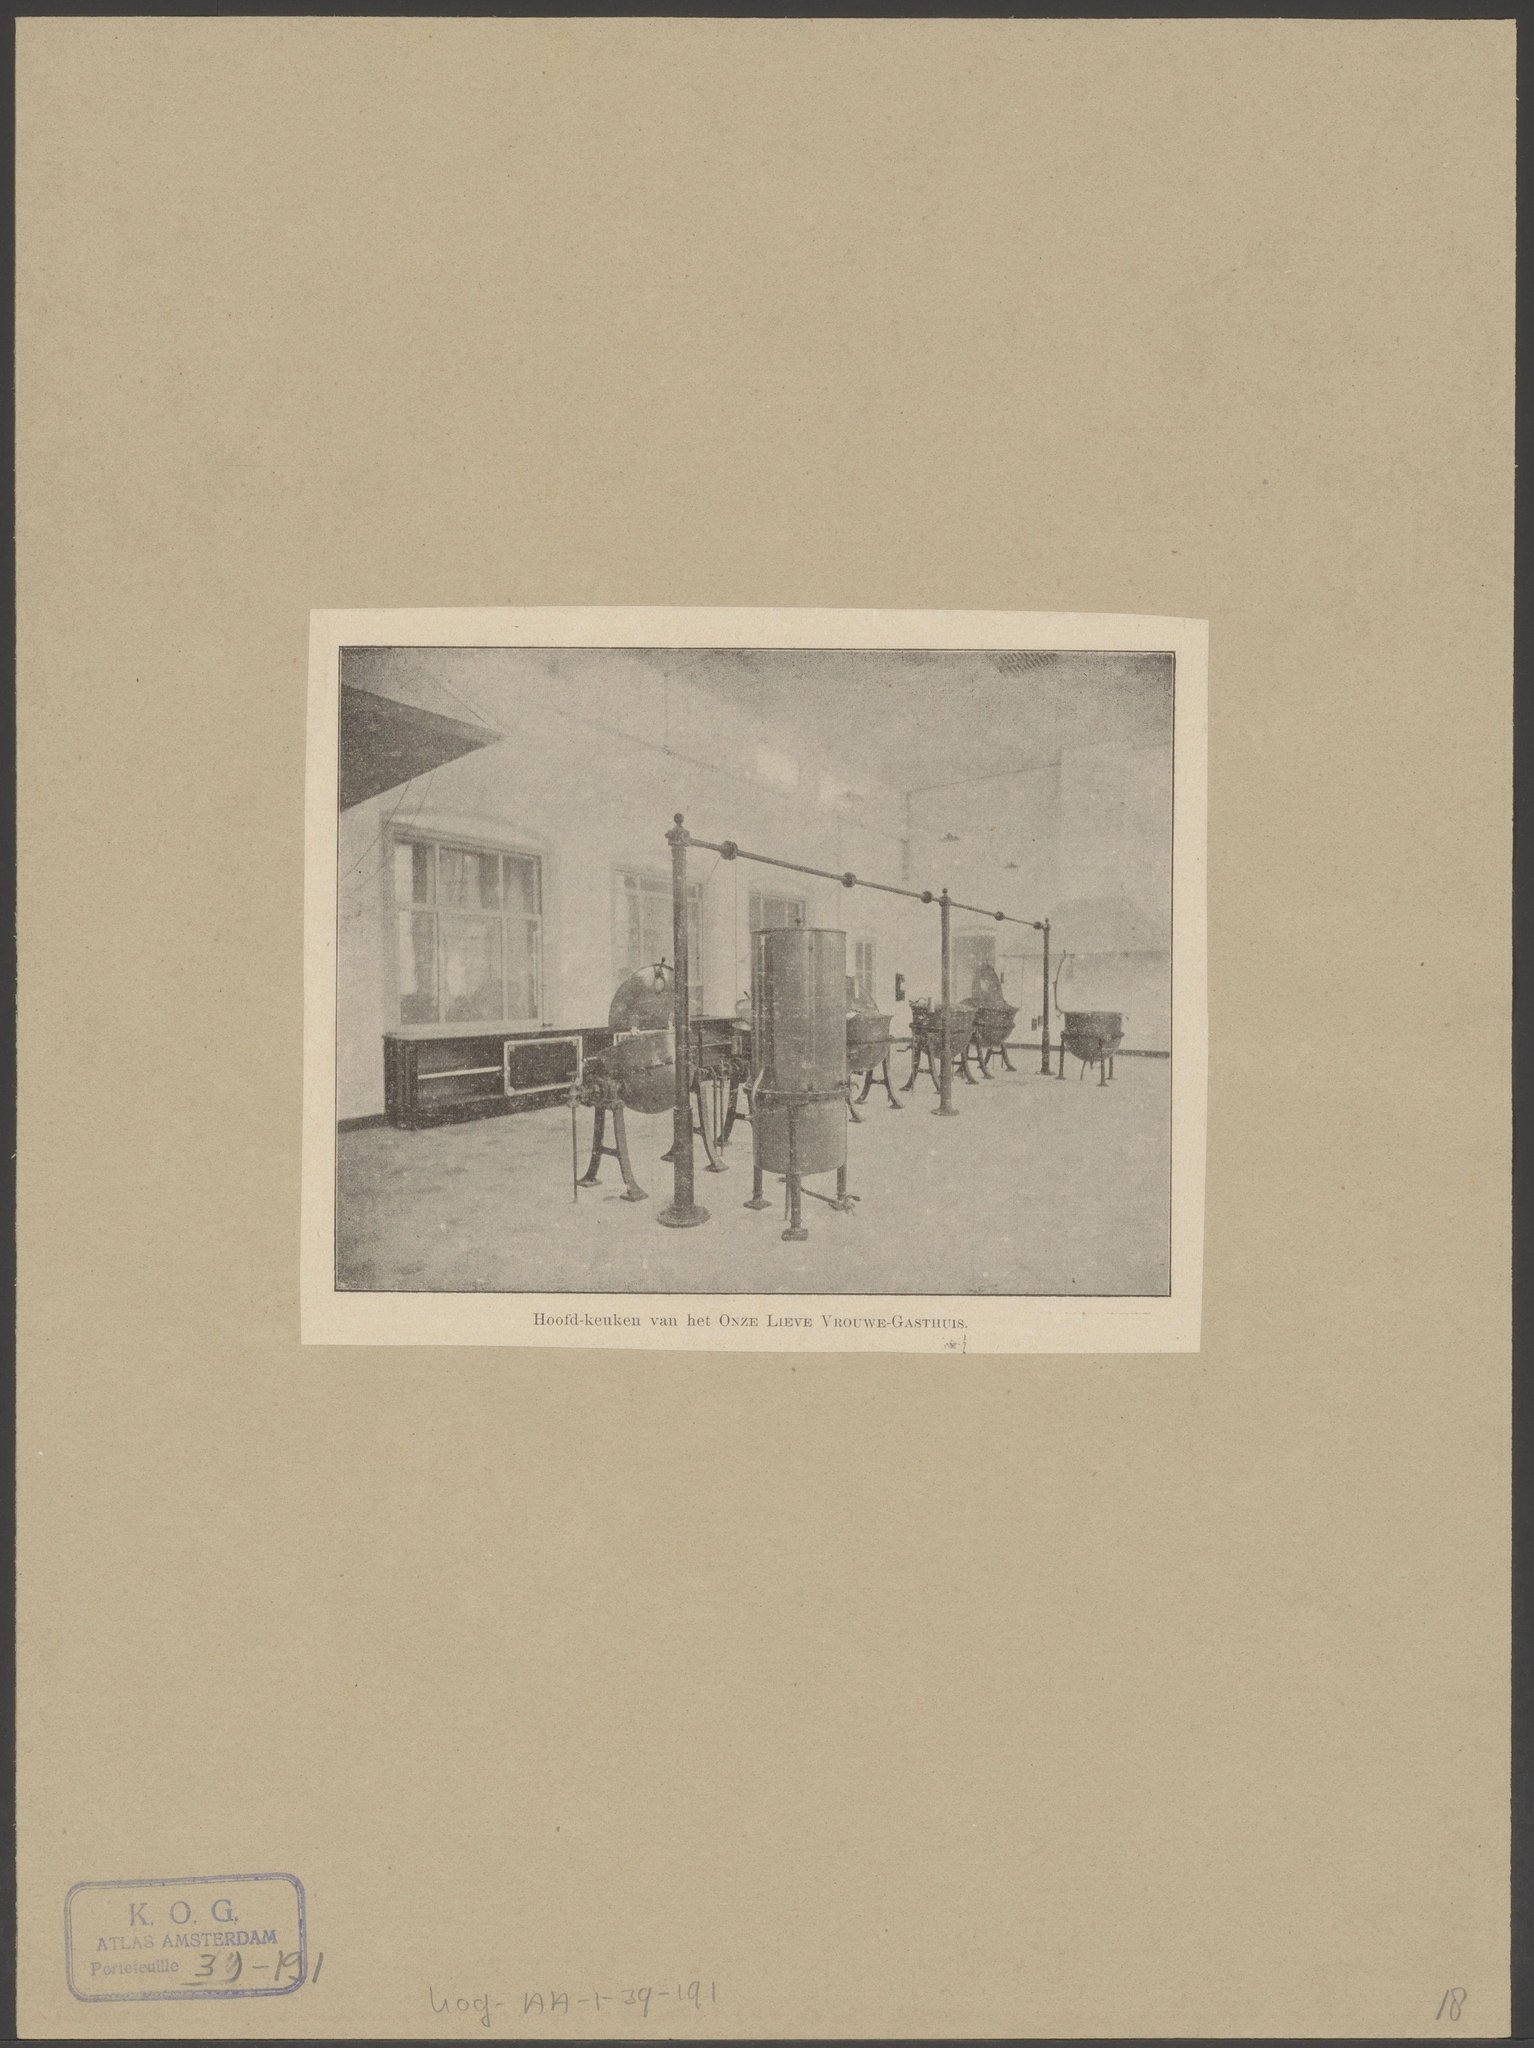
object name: photomechanical print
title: Hoofd-keuken van het Onze Lieve Vrouwe-Gasthuis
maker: Anonymous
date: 1898-1915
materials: paper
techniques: letterpress printing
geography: netherlands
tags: kitchen, hospital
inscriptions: collector's mark: Lugt 1641b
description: Onderwerpsrubriek binnen de Atlas Amsterdam: Armwezen en liefdadige instellingen: V. Ziekenhuizen: O.L. Vrouwe Gasthuis.